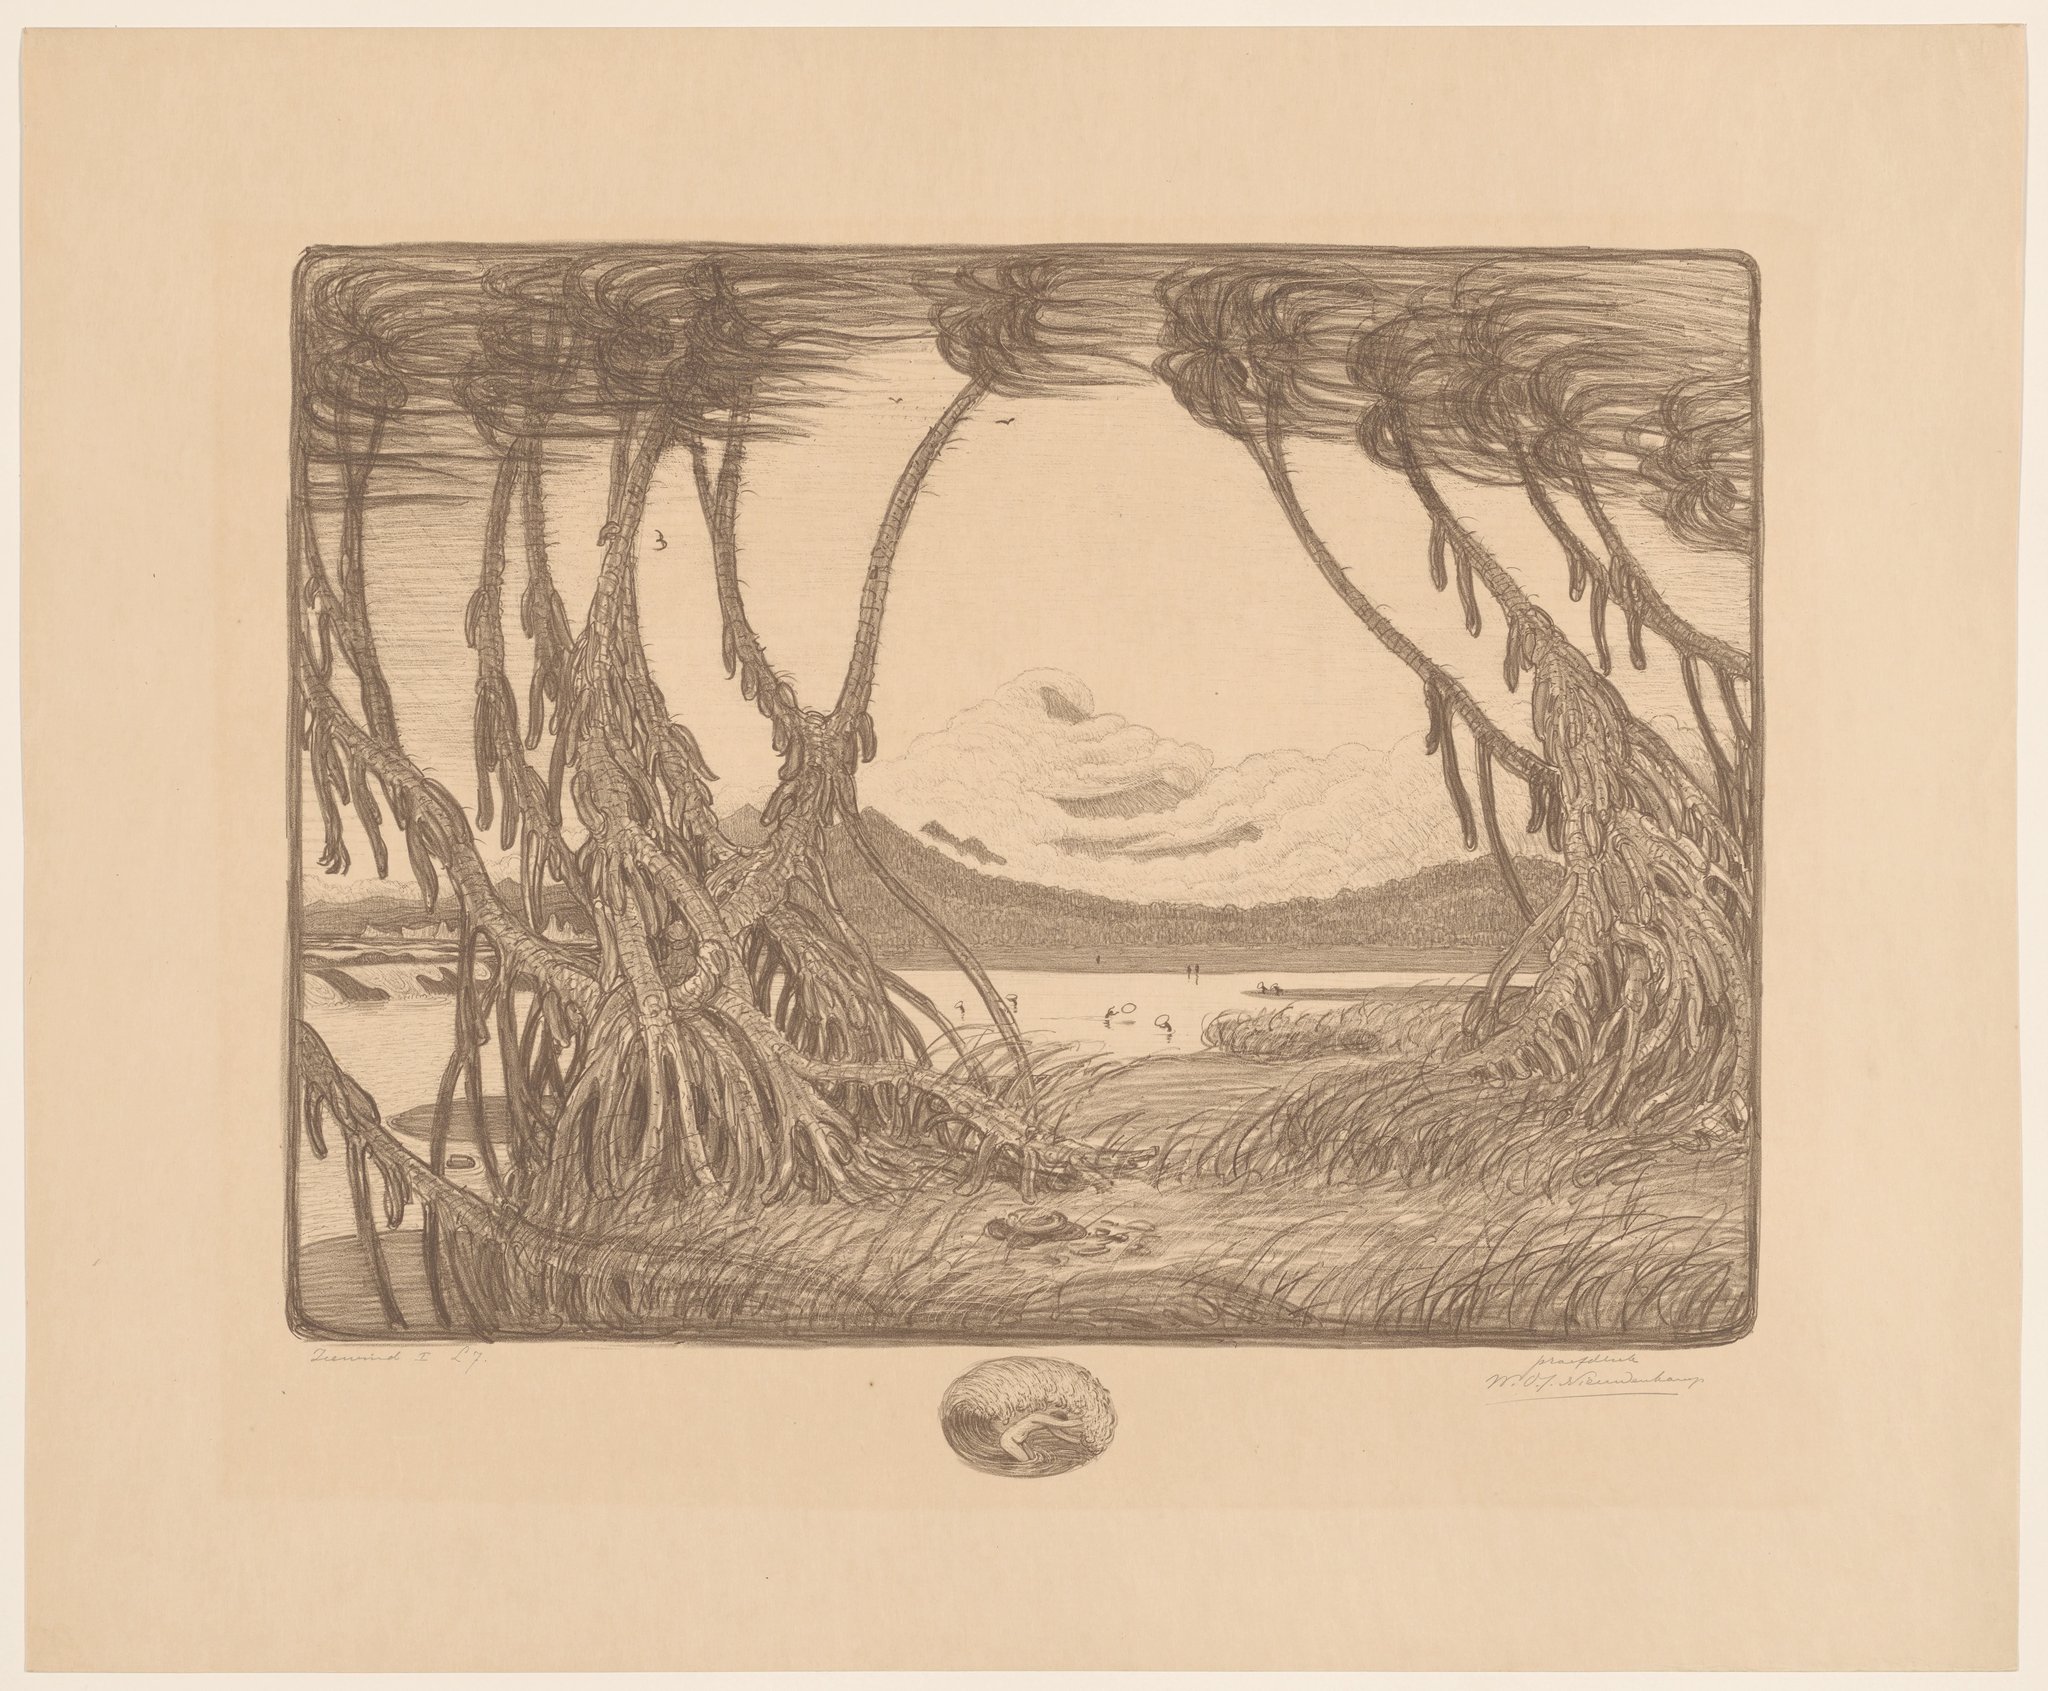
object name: print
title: Indisch landschap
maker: wijnand otto jan nieuwenkamp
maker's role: draughtsman, print maker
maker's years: 1874-1950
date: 1903-1918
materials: paper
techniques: lithograph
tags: sea (+ landscape with figures, staffage), java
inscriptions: collector's mark: Lugt 2233